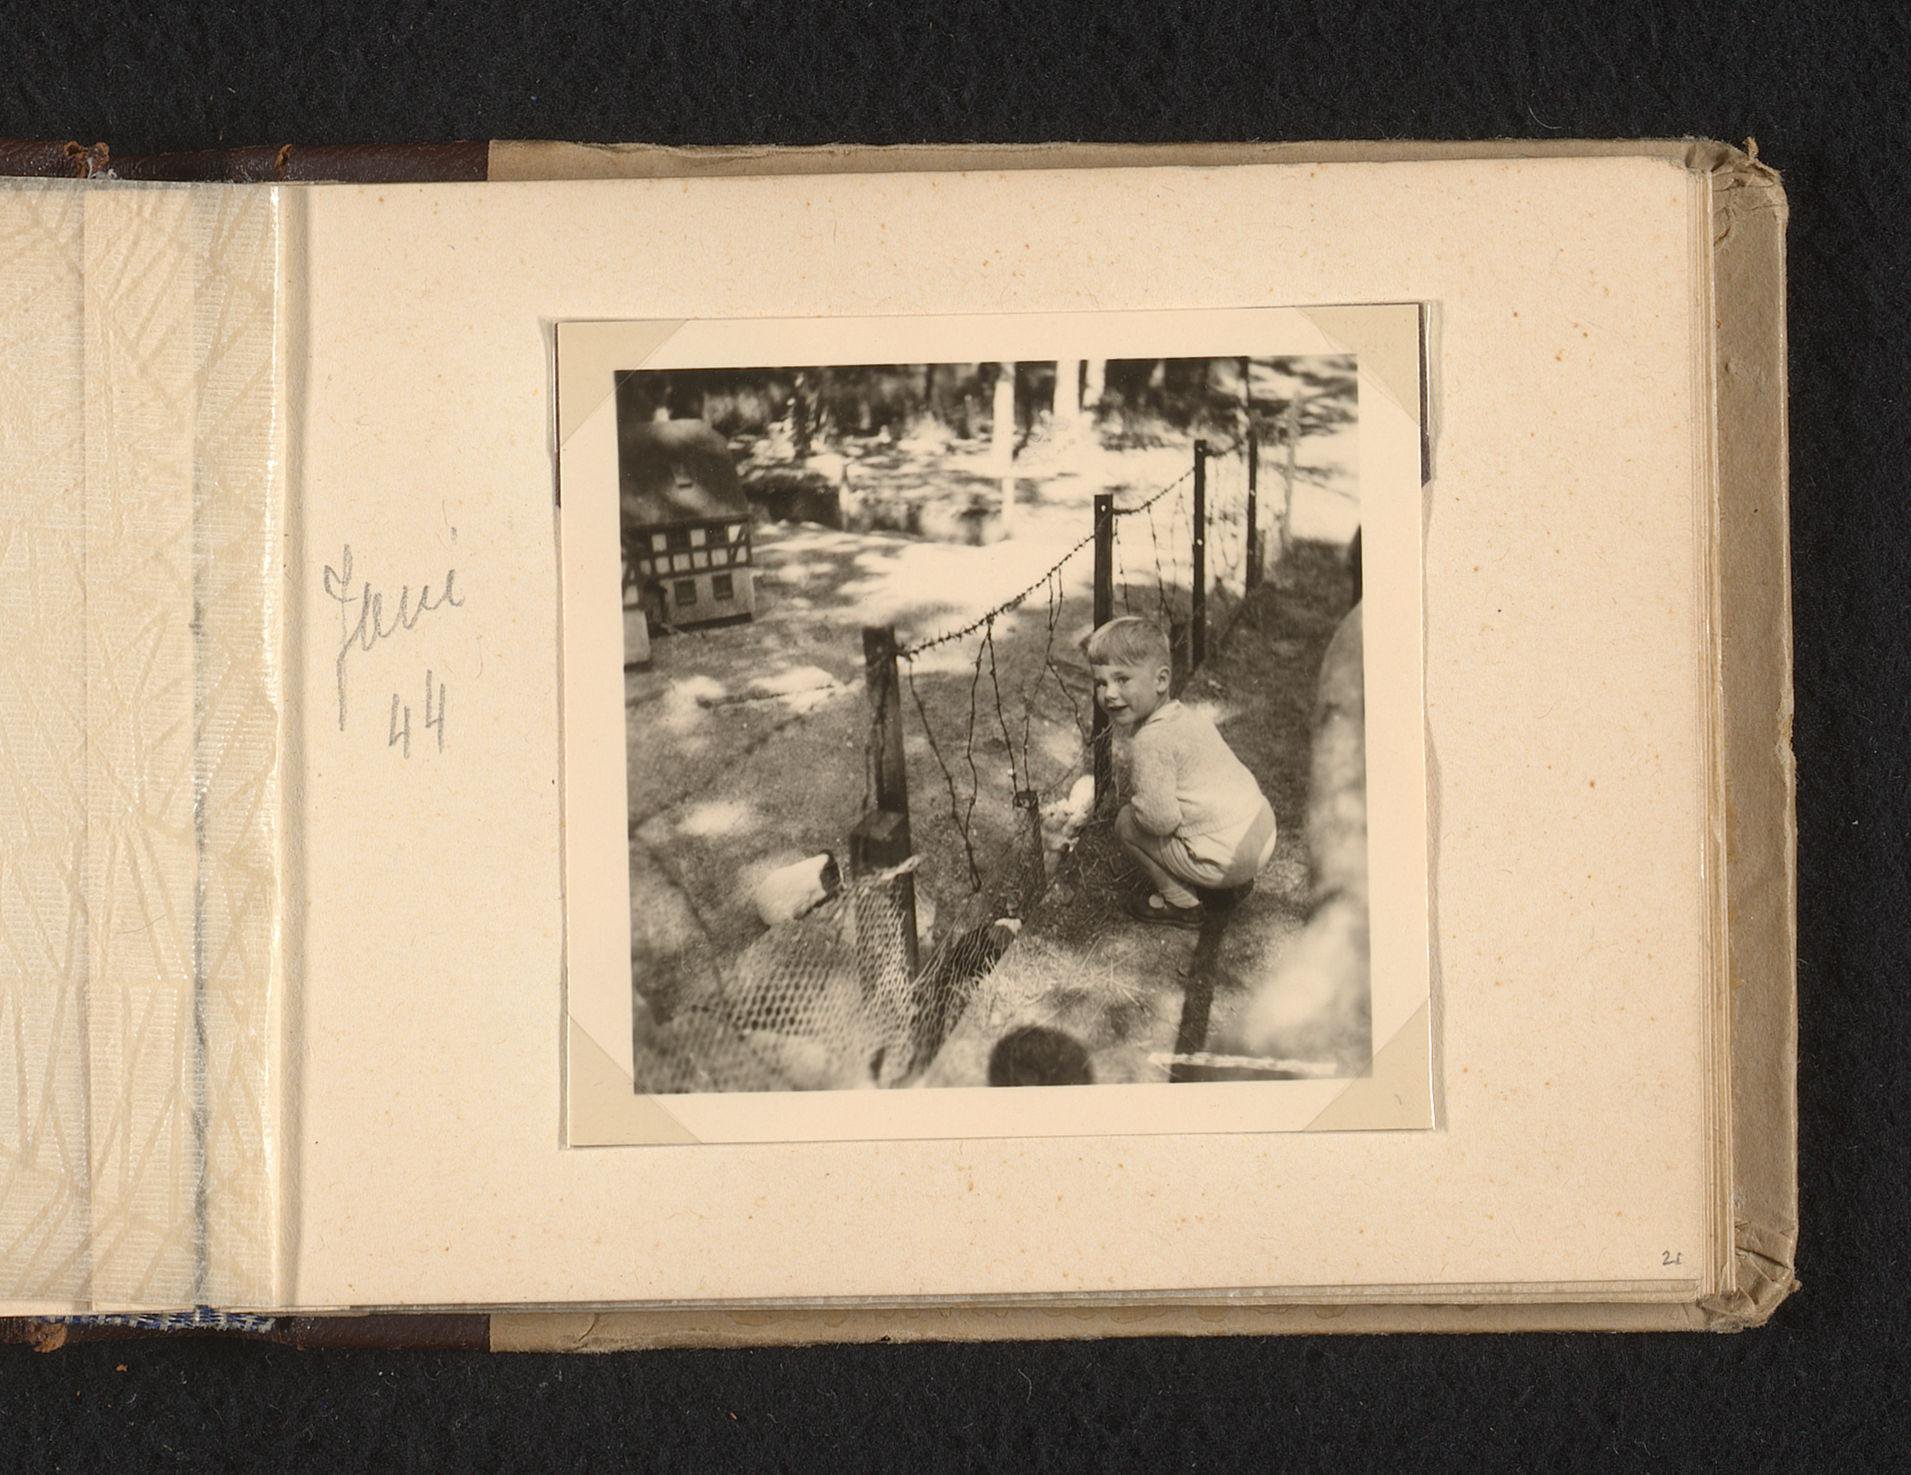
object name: album leaf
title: Norbert Peter van den Berg als peuter bij een verblijf met cavia's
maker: norbert peter van den berg (1941-)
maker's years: 1941-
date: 1906-1944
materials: paper, cardboard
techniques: gelatin silver print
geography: netherlands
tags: amsterdam, norbert peter van den berg (1941-), toddler, rodents